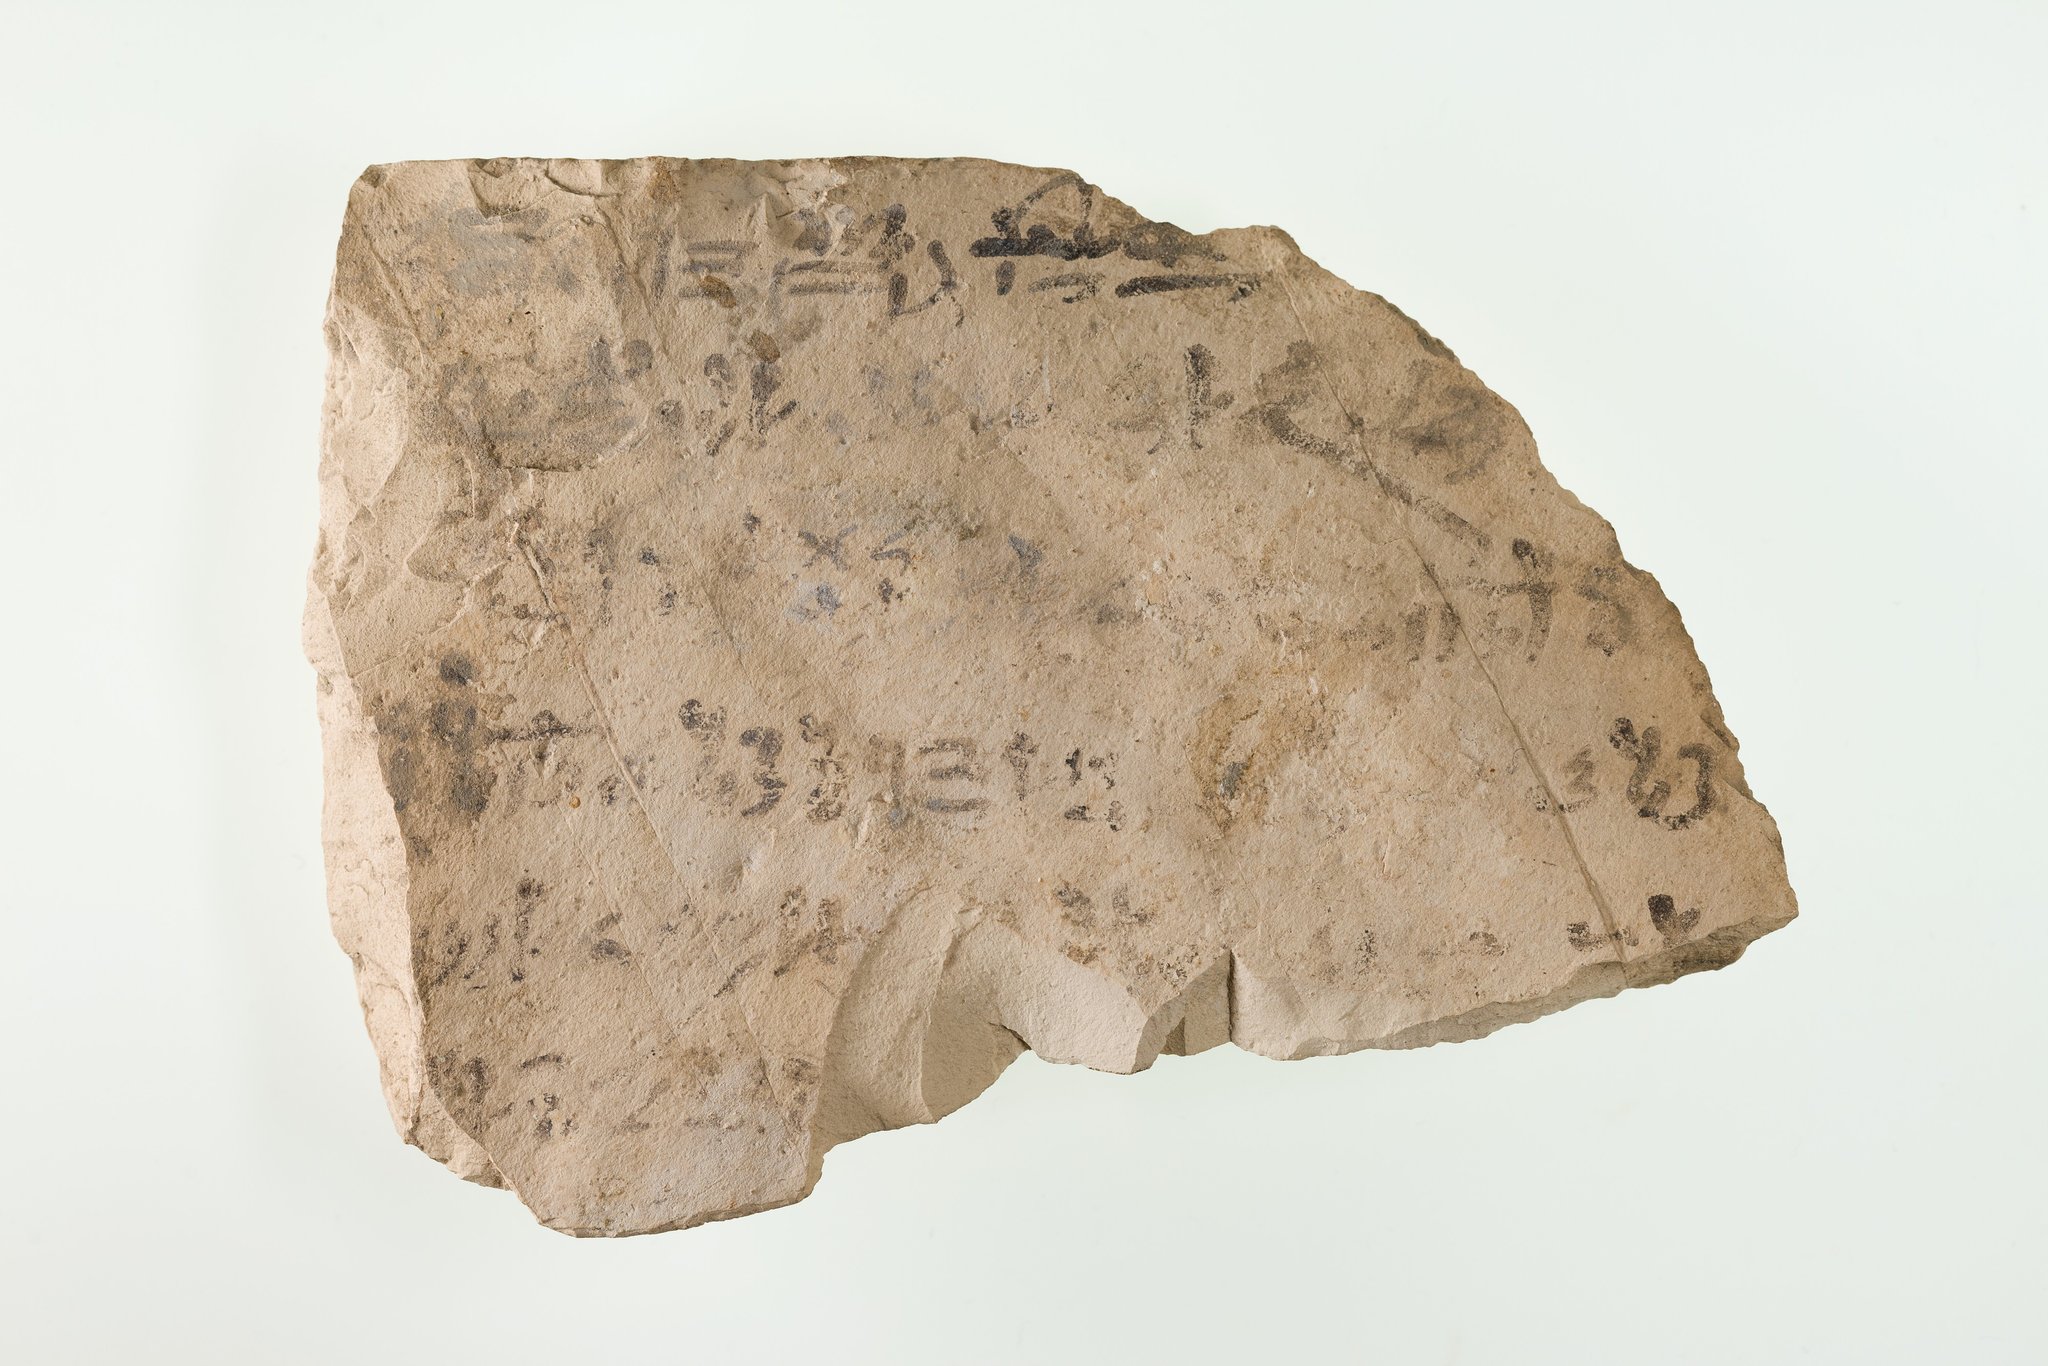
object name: ostracon, hieratic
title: Ostracon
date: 1550-1295 BCE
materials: ink, limestone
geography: egypt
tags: hieratic